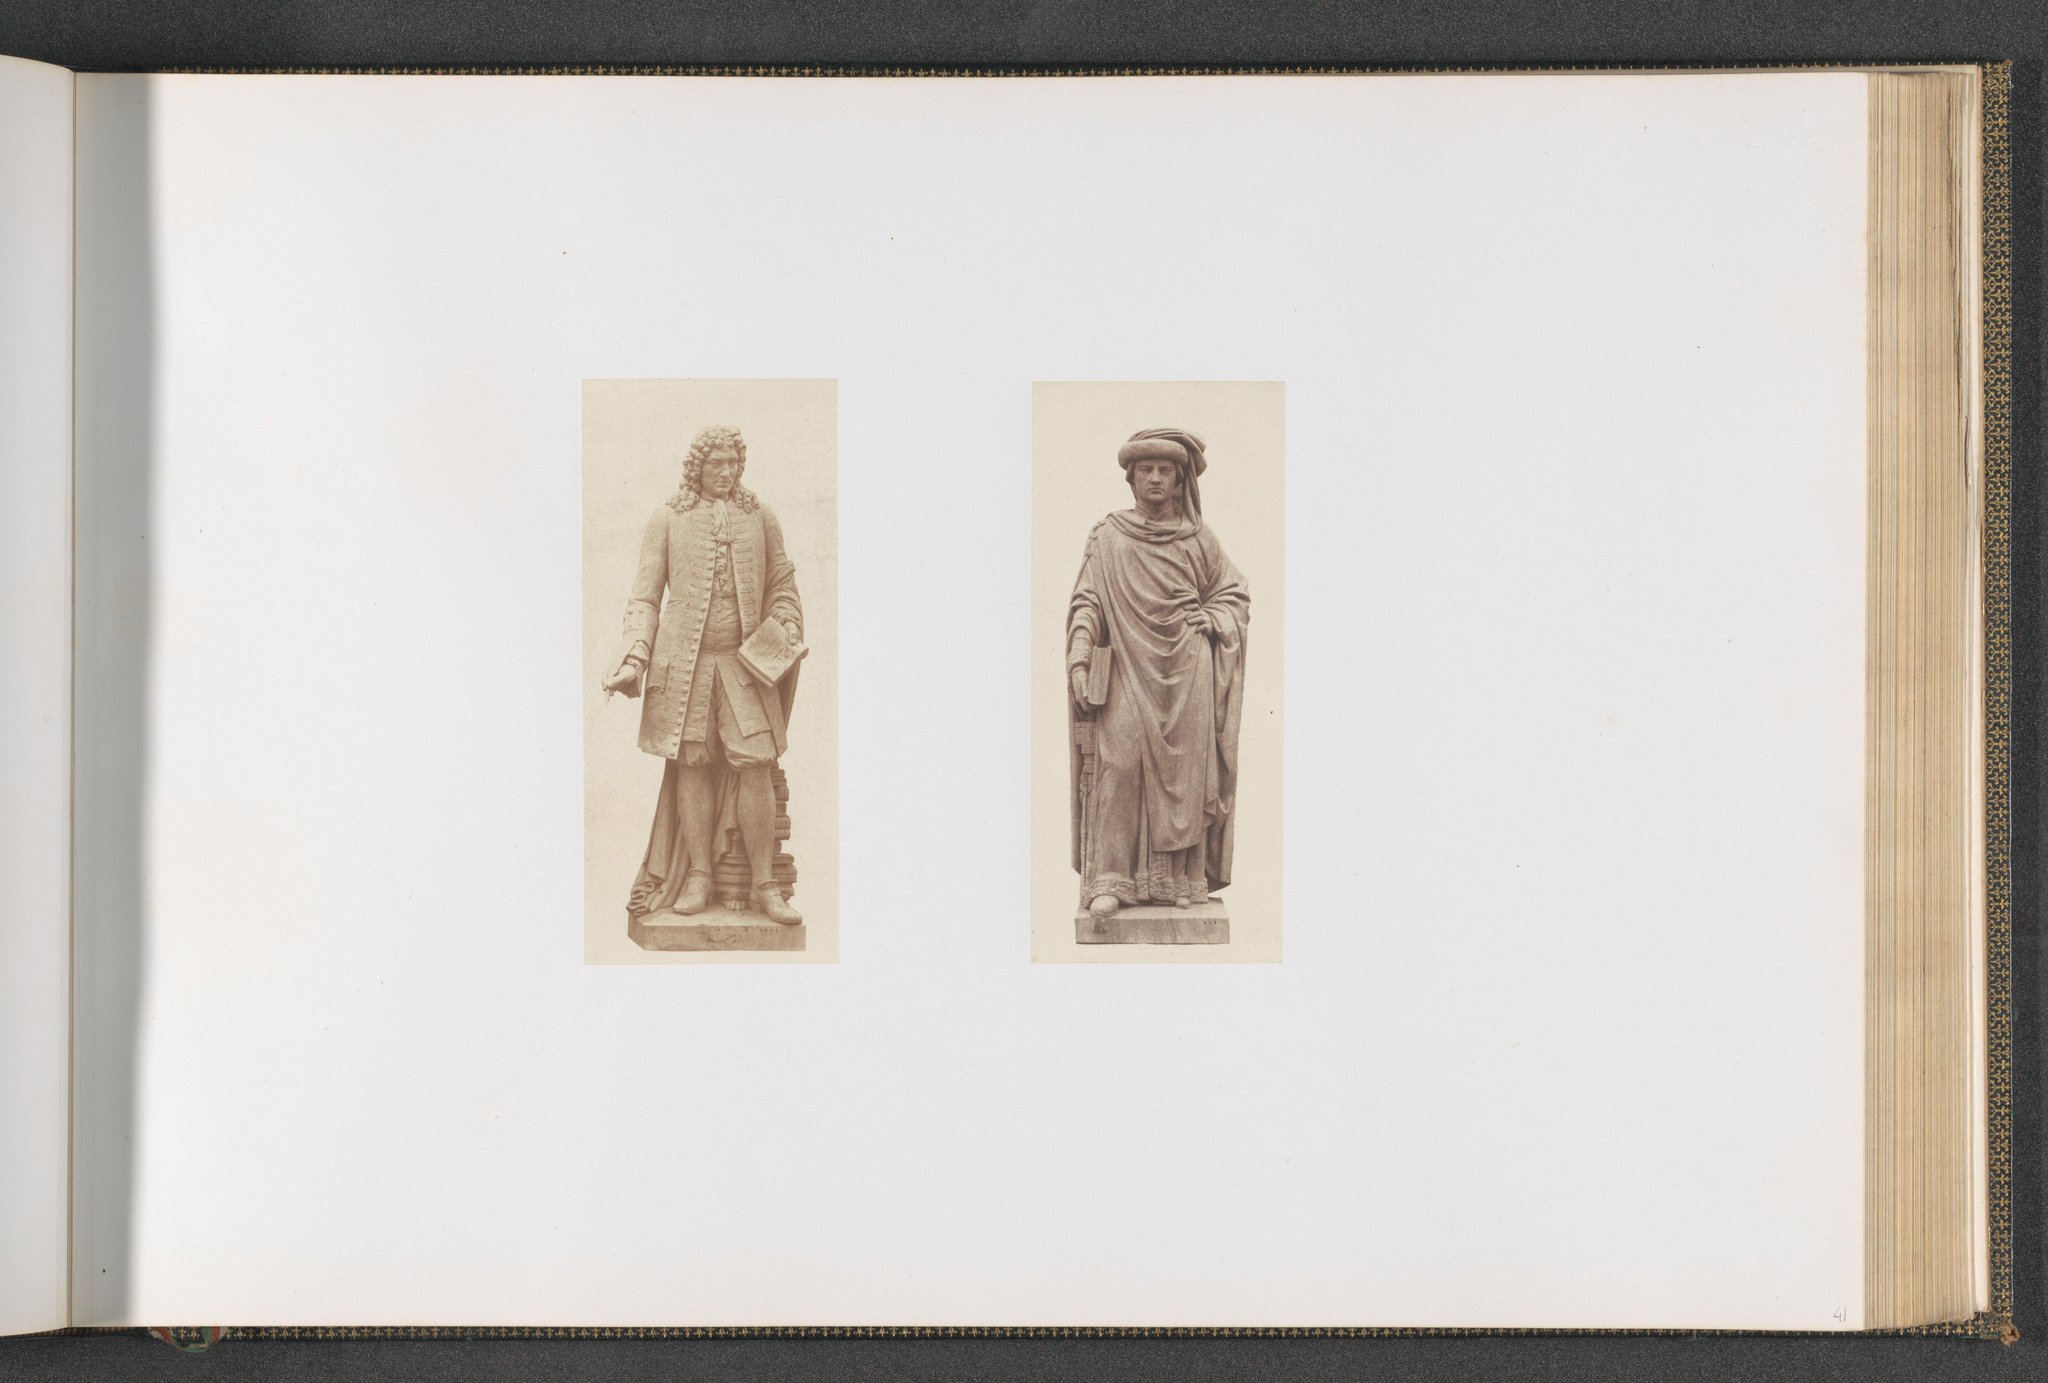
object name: album leaf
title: Gipsmodellen voor beeldhouwwerken op het Palais du Louvre: links "Regnard" door Théodore Gruyère en rechts "Jacques Coeur" door Elias Robert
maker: édouard denis baldus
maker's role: fotograaf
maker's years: 1813-1889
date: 1855-1857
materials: paper, photographic support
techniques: salted paper print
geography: paris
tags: piece of sculpture, reproduction of a piece of sculpture, permanent exhibition, museum, paris, tuileries palace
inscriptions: number: ‘1001 en 951’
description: Onderdeel van Réunion des Tuileries au Louvre 1852-1857, album 2.